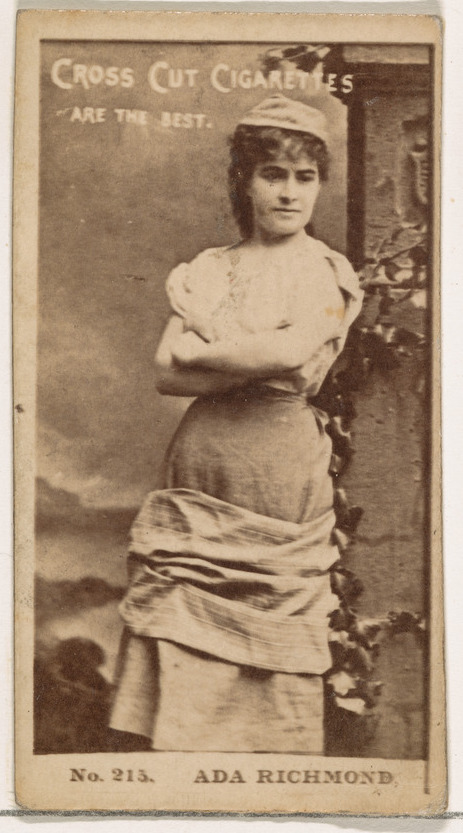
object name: print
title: Card Number 215, Ada Richmond, from the Actors and Actresses series (N145-2) issued by Duke Sons & Co. to promote Cross Cut Cigarettes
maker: w. duke, sons & co.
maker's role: publisher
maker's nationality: american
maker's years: 1870-1920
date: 1880-1889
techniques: albumen silver print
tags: portraits,women,actresses